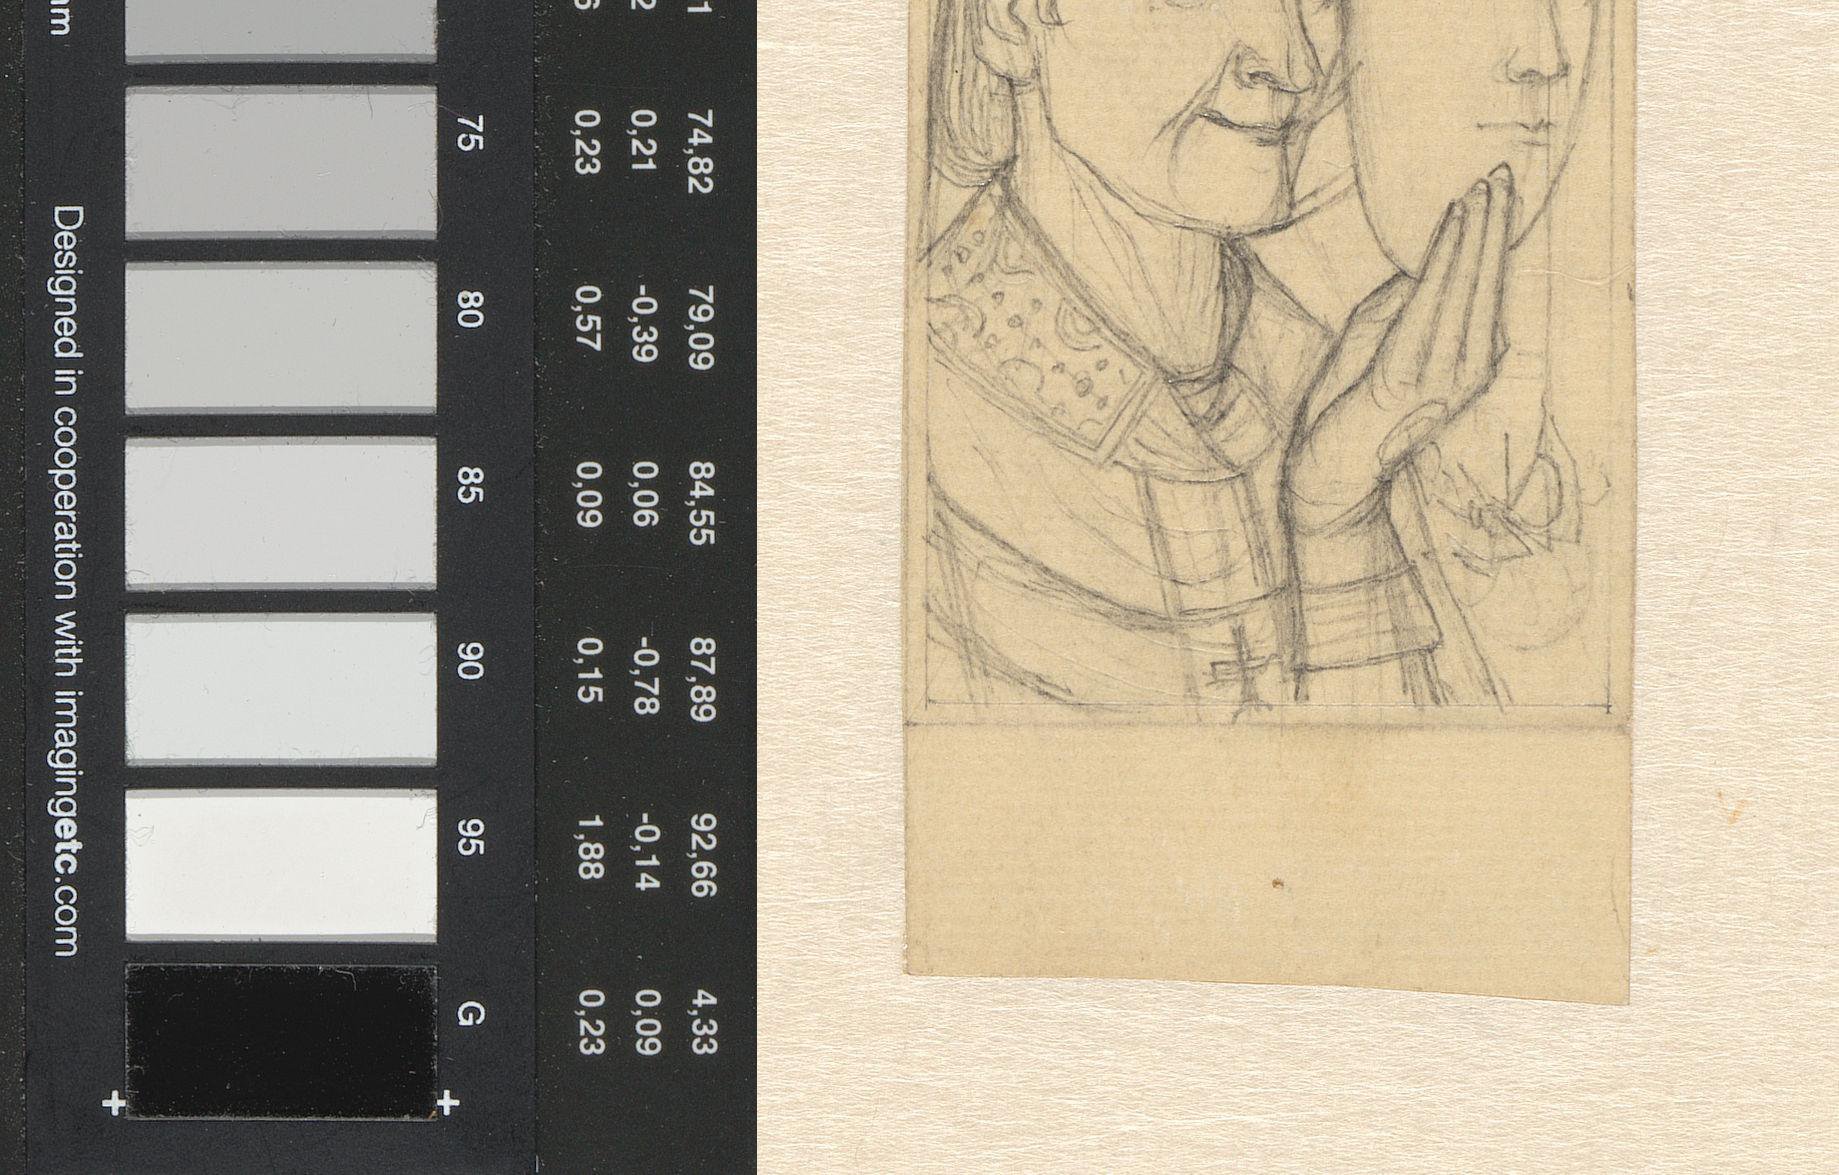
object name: drawing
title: De listige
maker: mathieu lauweriks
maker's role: designer, draughtsman, print maker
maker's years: 1864-1932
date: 1894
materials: paper, pencil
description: Man met hoofddeksel met kroonrand houdt een masker in zijn hand.